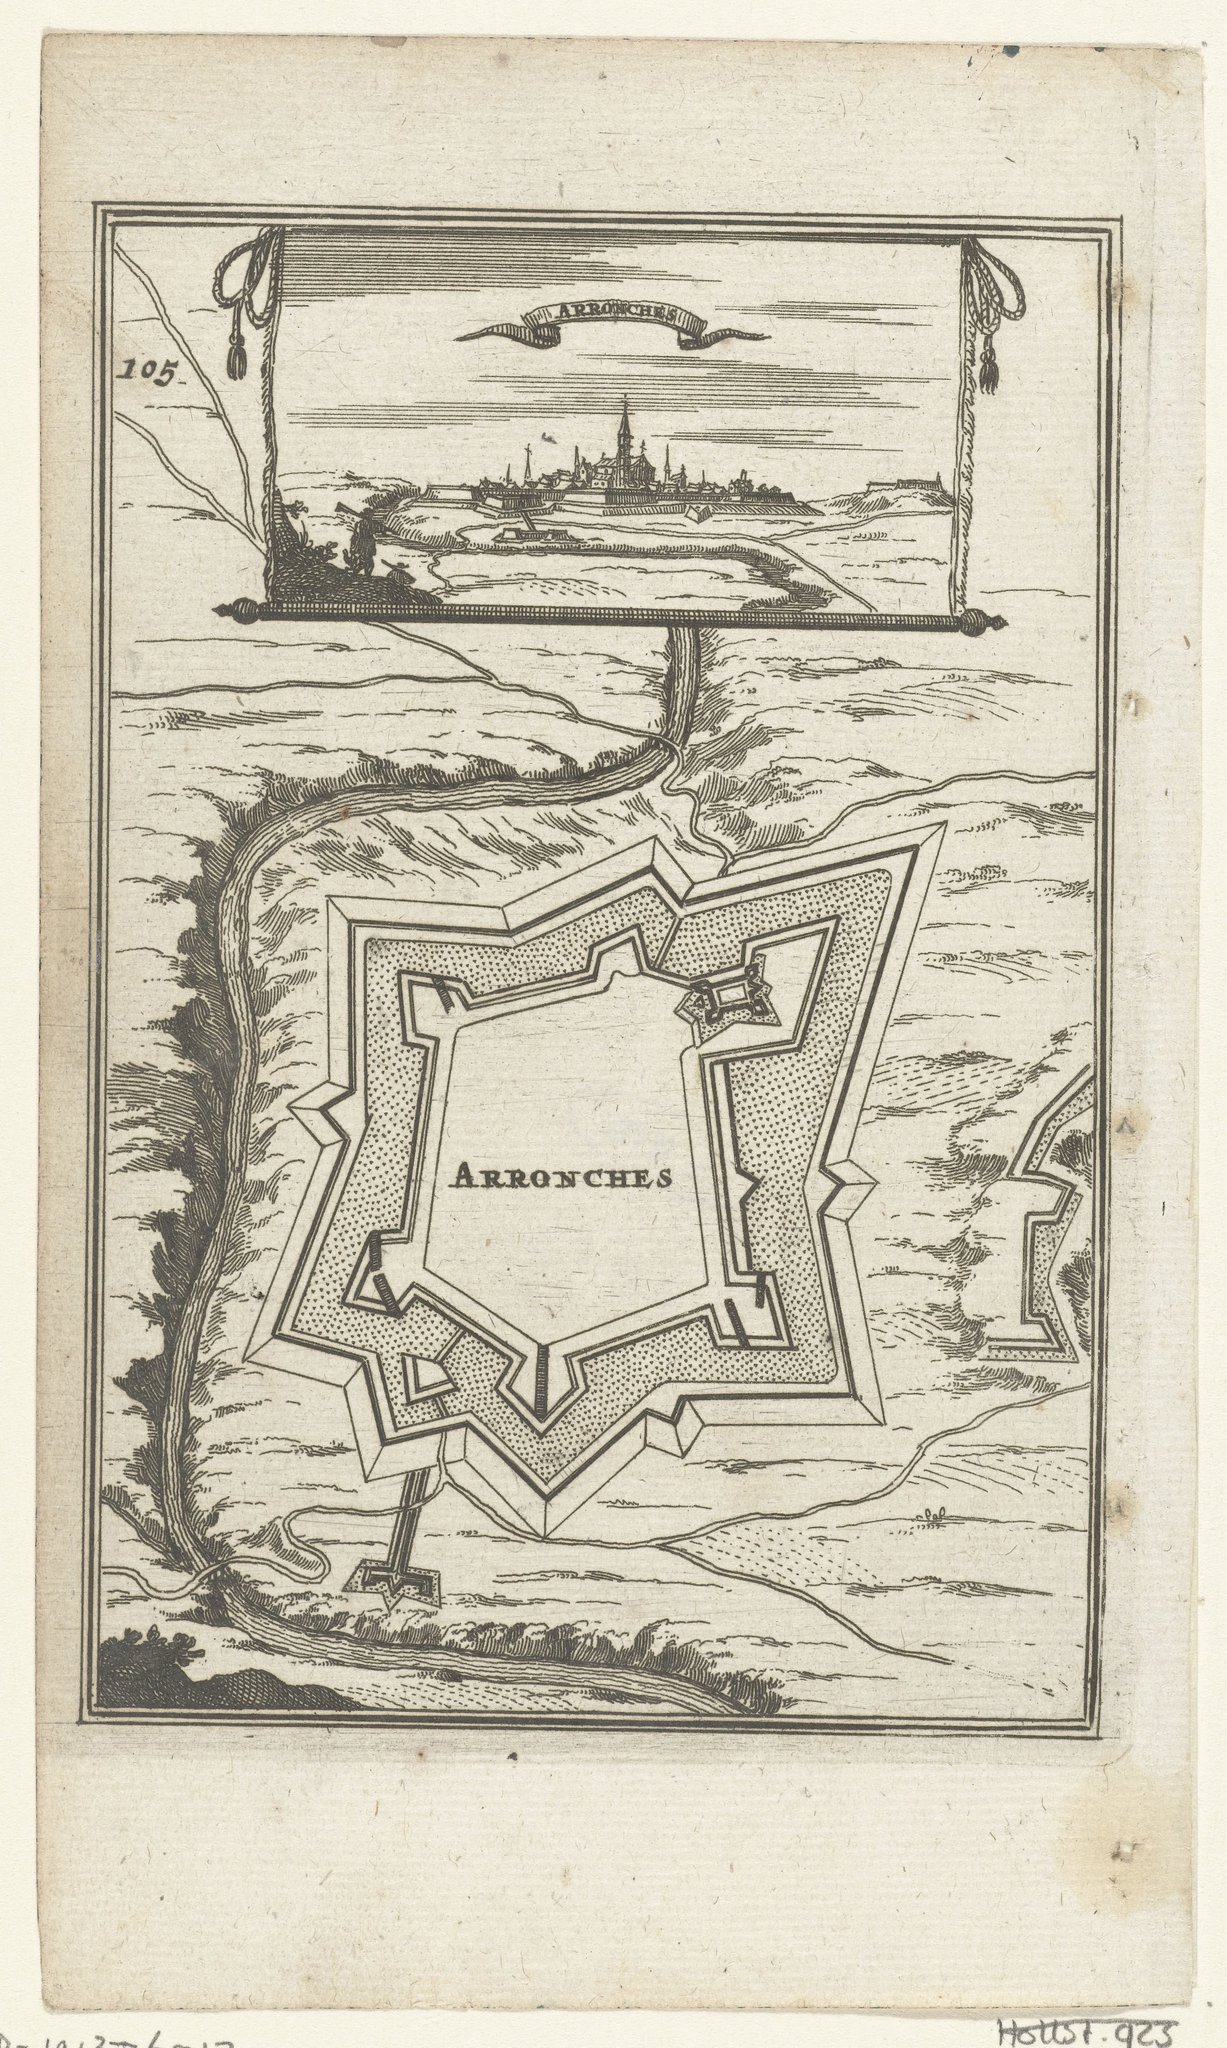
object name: print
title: Illustratie voor 'Den Arbeid van Mars' van Allain Manesson Mallet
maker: romeyn de hooghe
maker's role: draughtsman, goldsmith, painter, print maker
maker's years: 1645-1708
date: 1672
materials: paper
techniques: etching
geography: amsterdam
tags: river, fortifications, military engineering, prospect of city, town panorama, silhouette of city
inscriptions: collector's mark: Lugt 2228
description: Grondplan van een vesting aan een rivier (Arronches). Daarboven, als op een doek of stuk papier, een gezicht op de betreffende stad. In de hoek linksboven het cijfer 105 (= het nummer van de pagina in het boek waartegenover de illustratie geplaatst is).